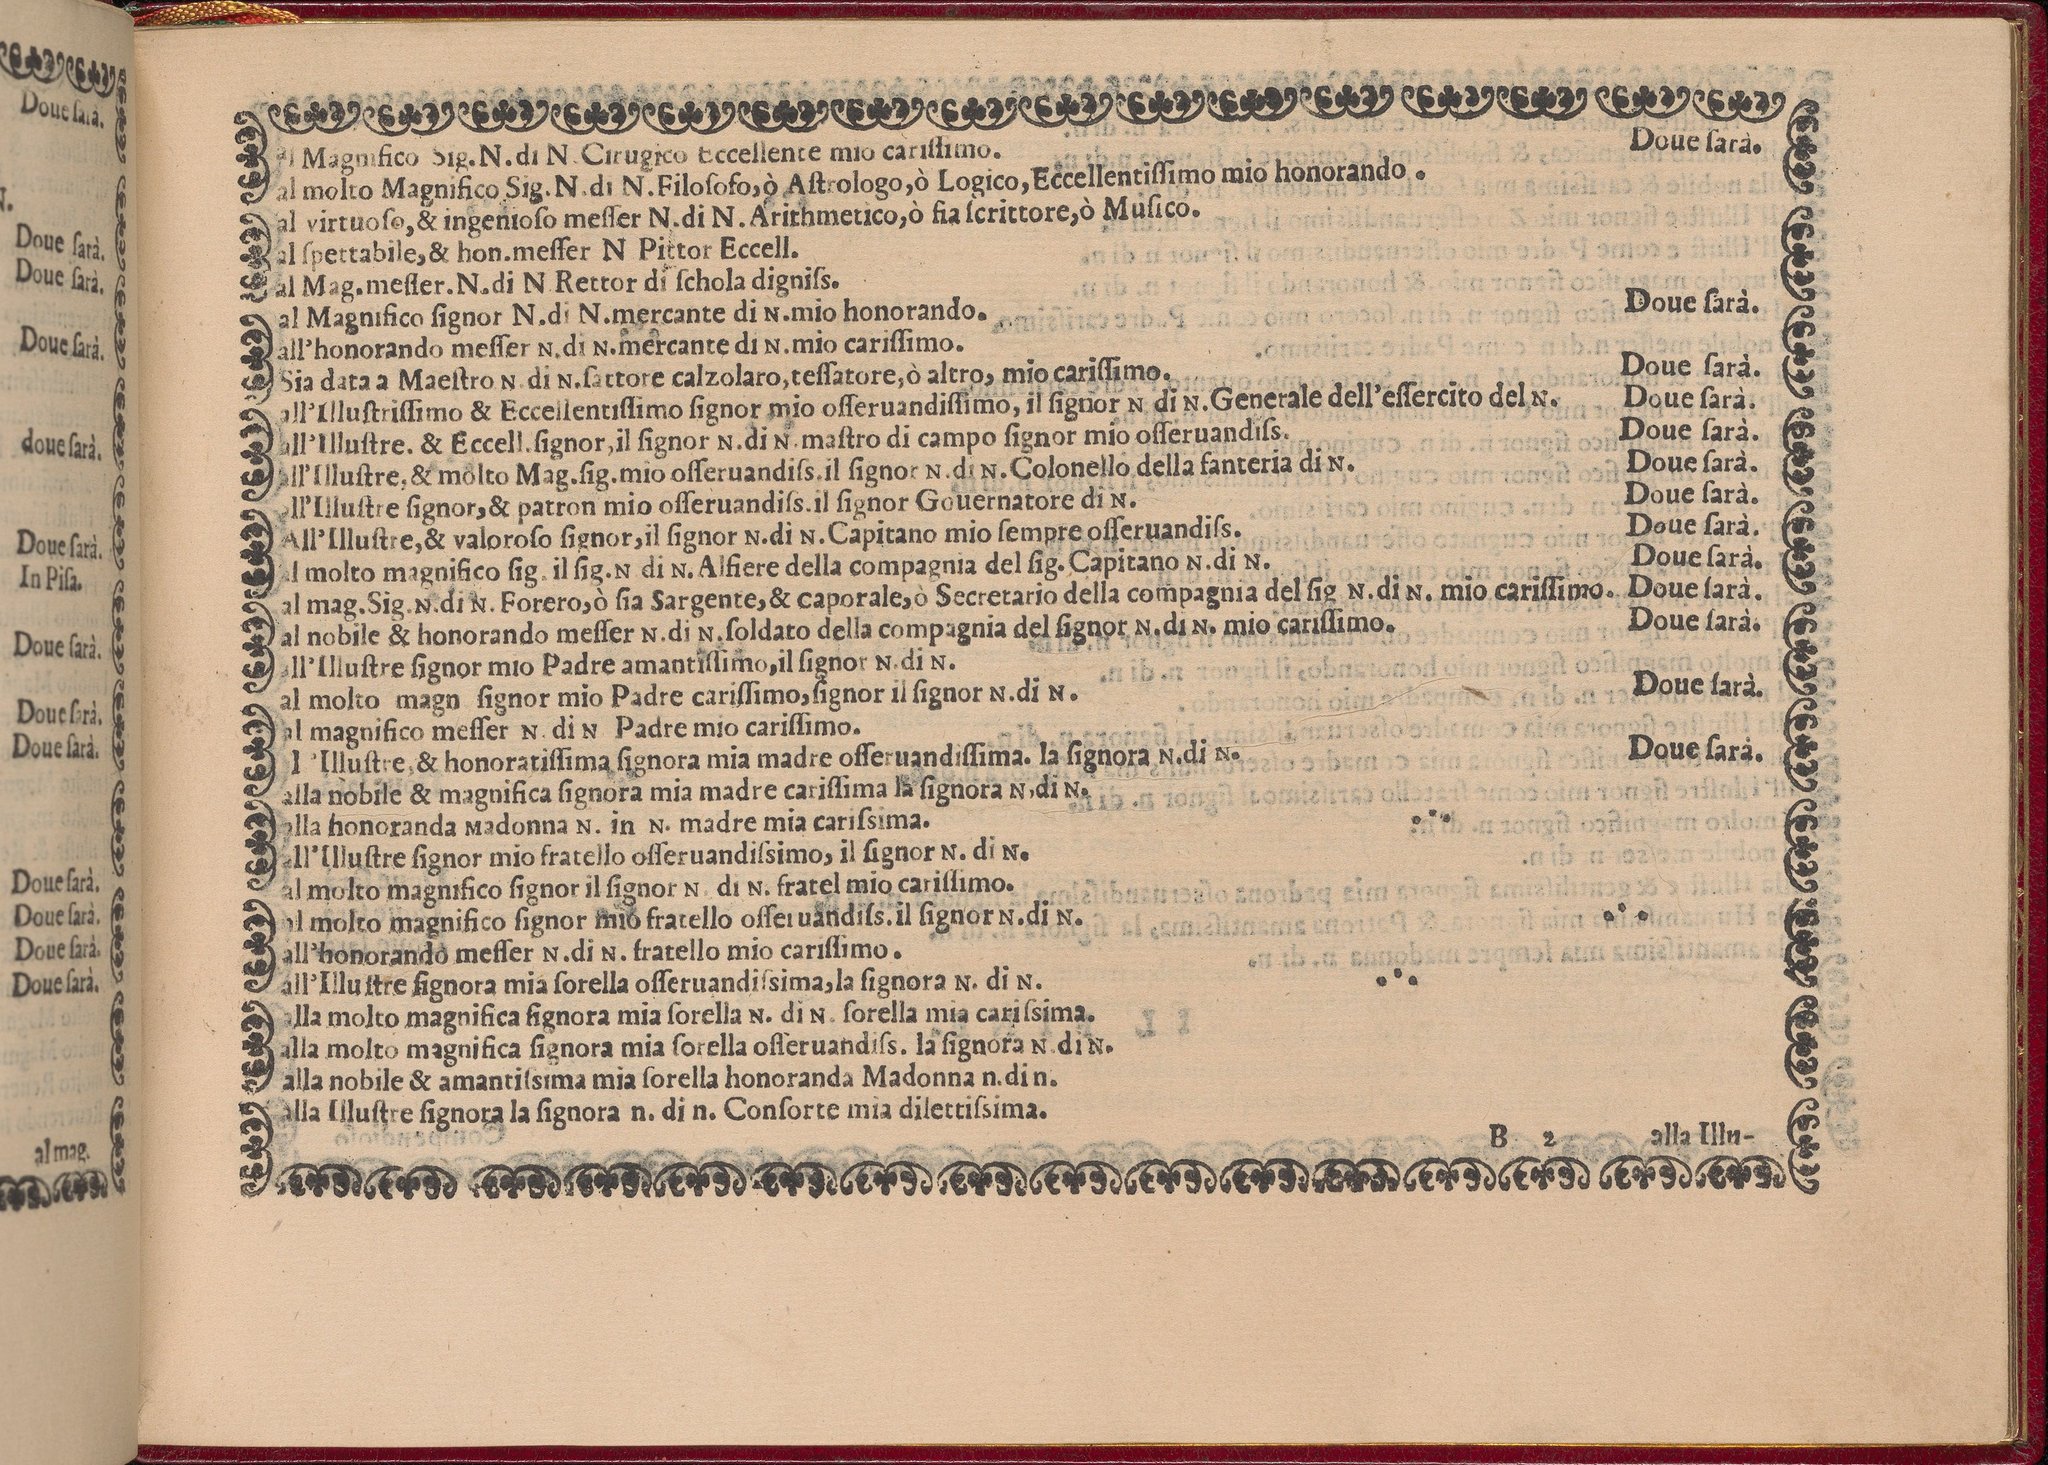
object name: book print ornament architecture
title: Ghirlanda: Di sei vaghi fiori scielti da piu famosi Giardini d'Italia, page 6 (recto)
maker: pietro paulo tozzi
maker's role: designer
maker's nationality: italian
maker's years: 1593-1628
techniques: drawing, etching